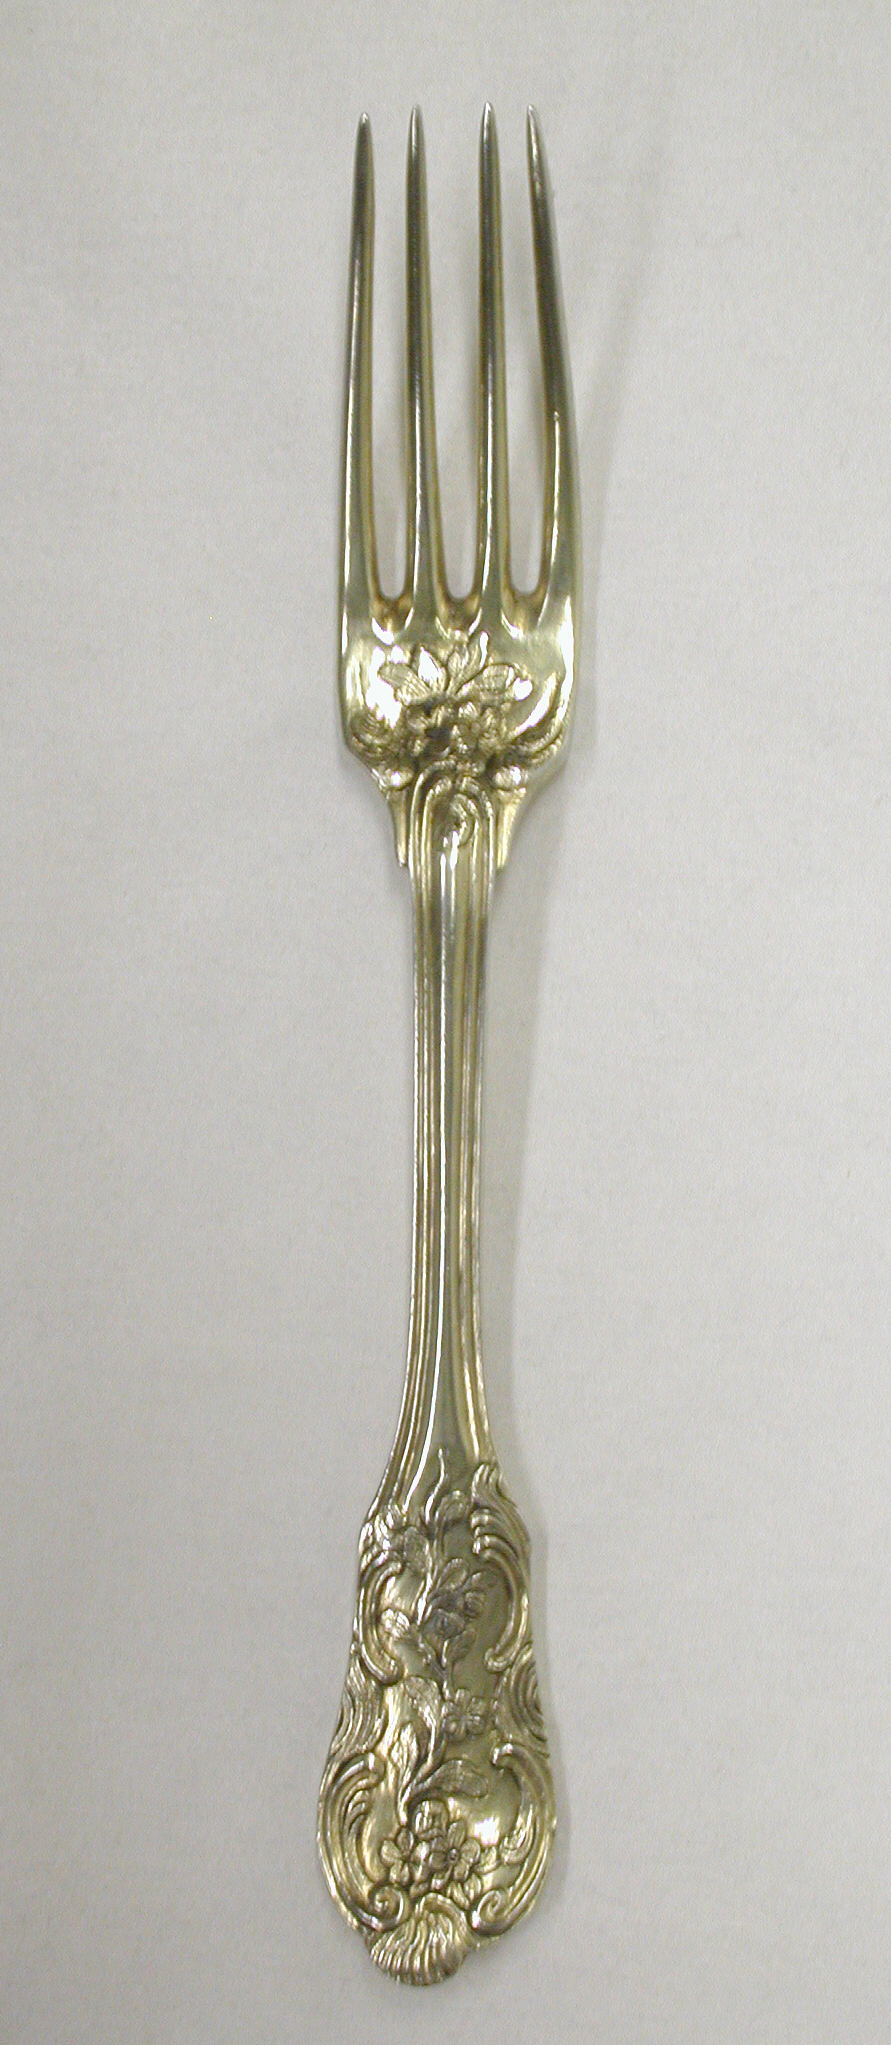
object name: fork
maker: johann beckert v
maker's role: maker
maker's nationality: german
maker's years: 1749-1777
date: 1743-1745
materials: silver gilt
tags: flowers